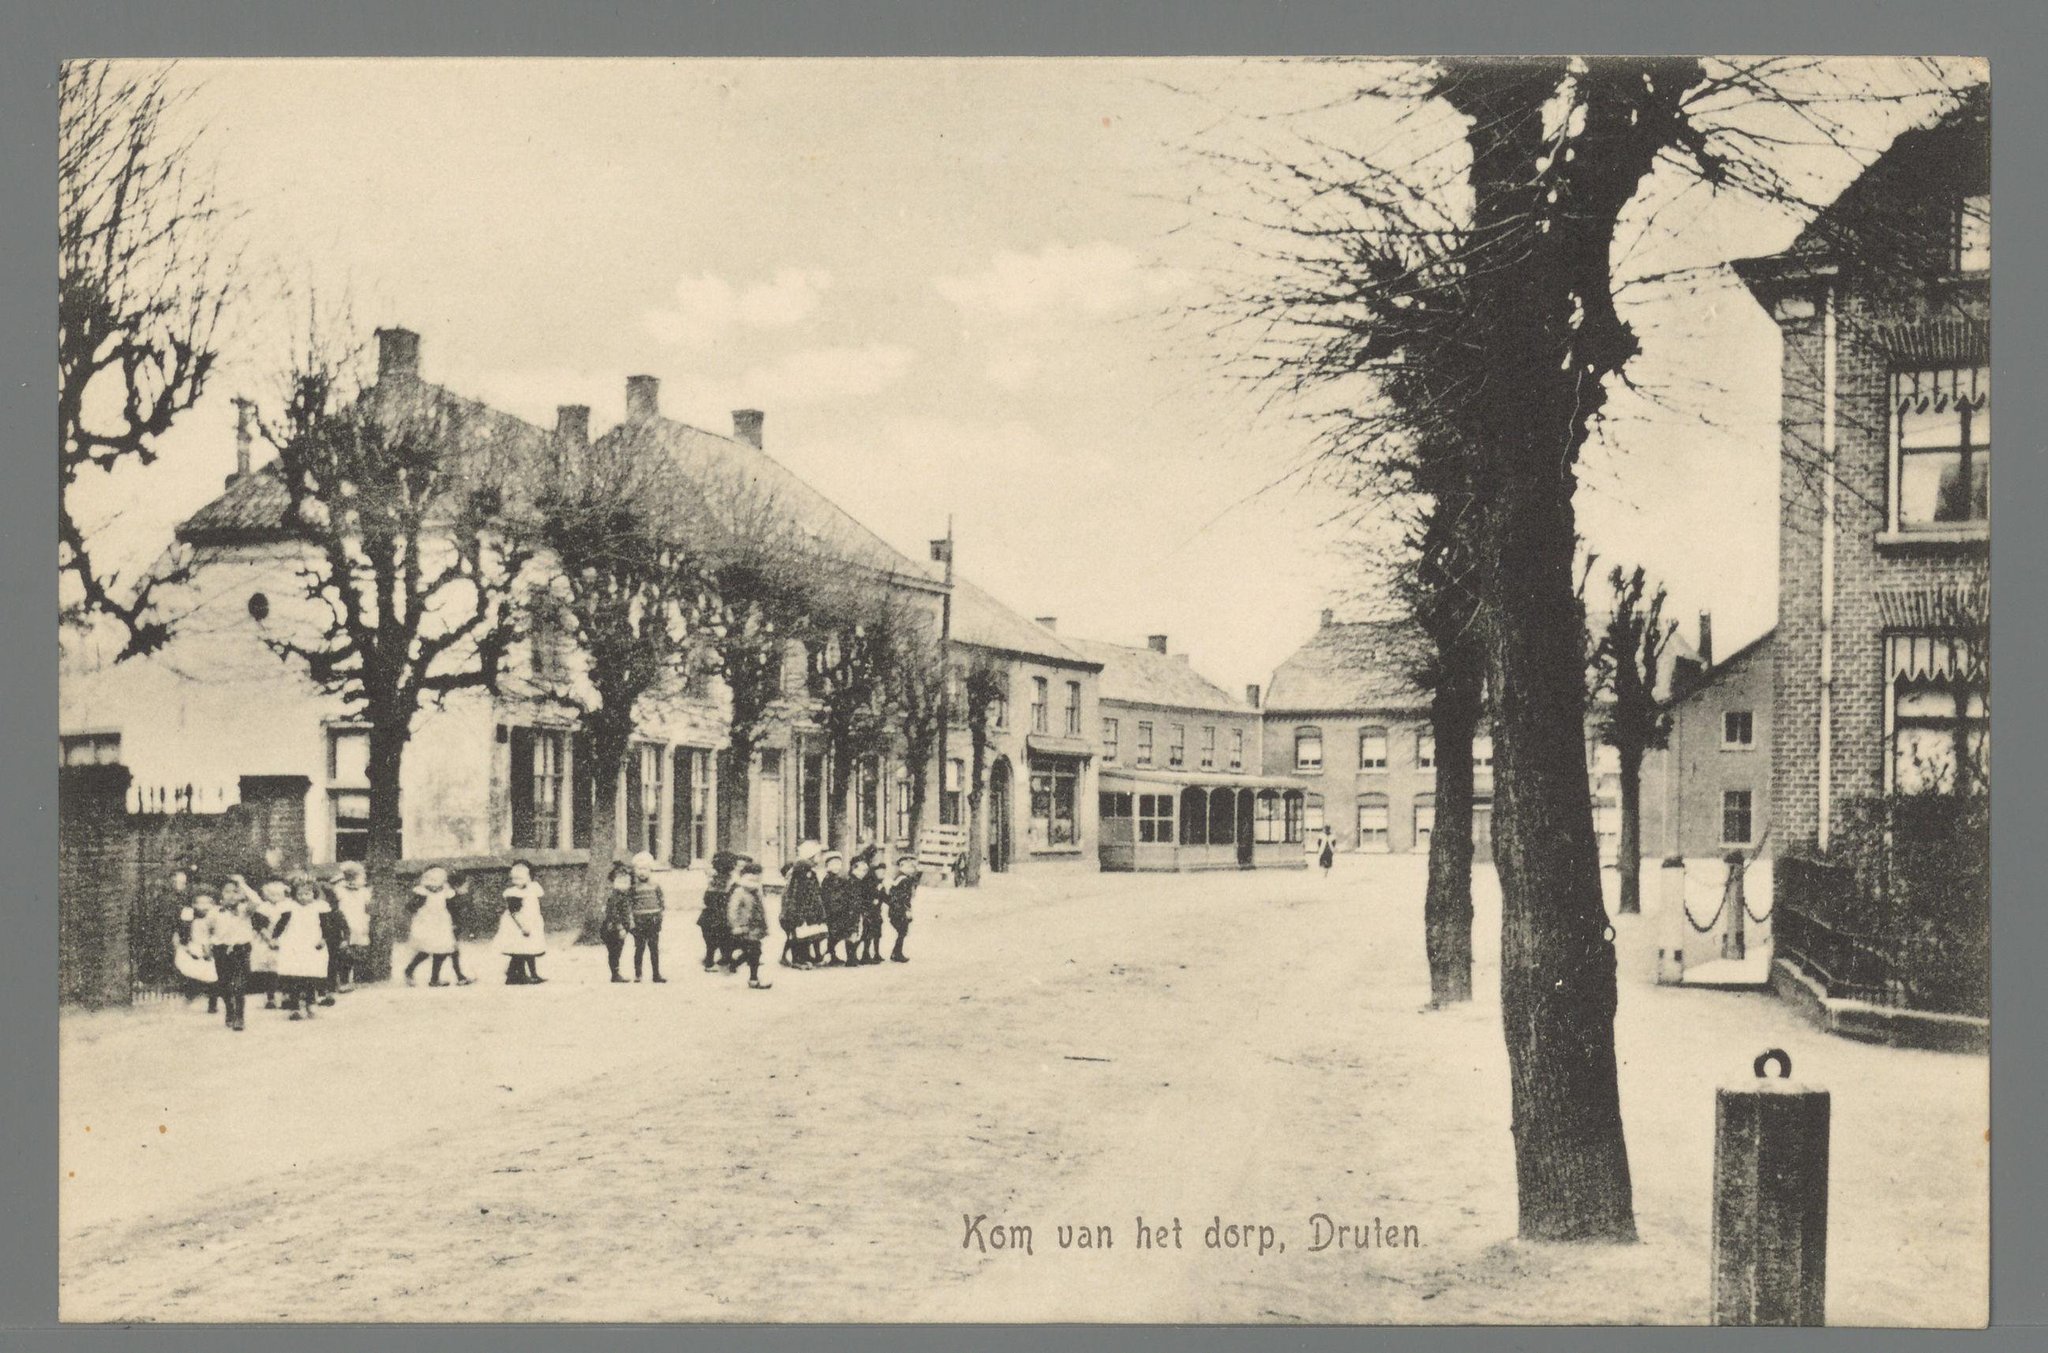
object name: photomechanical print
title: Kom van het dorp, Druten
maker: Anonymous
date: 1905-1930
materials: cardboard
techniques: photograph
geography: druten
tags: square, place, circus, etc.